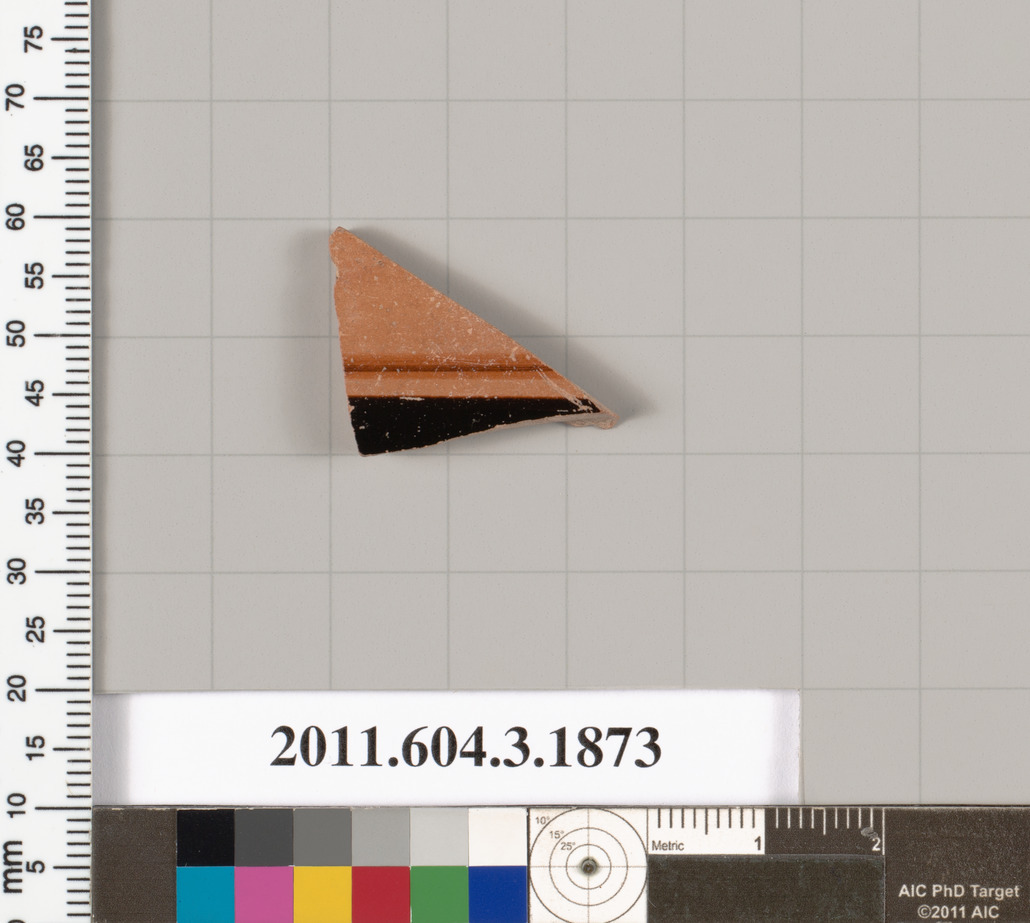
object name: kylix fragment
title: Terracotta fragment of a kylix: Band or lip cup (drinking cup)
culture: greek, attic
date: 560-525 BCE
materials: terracotta